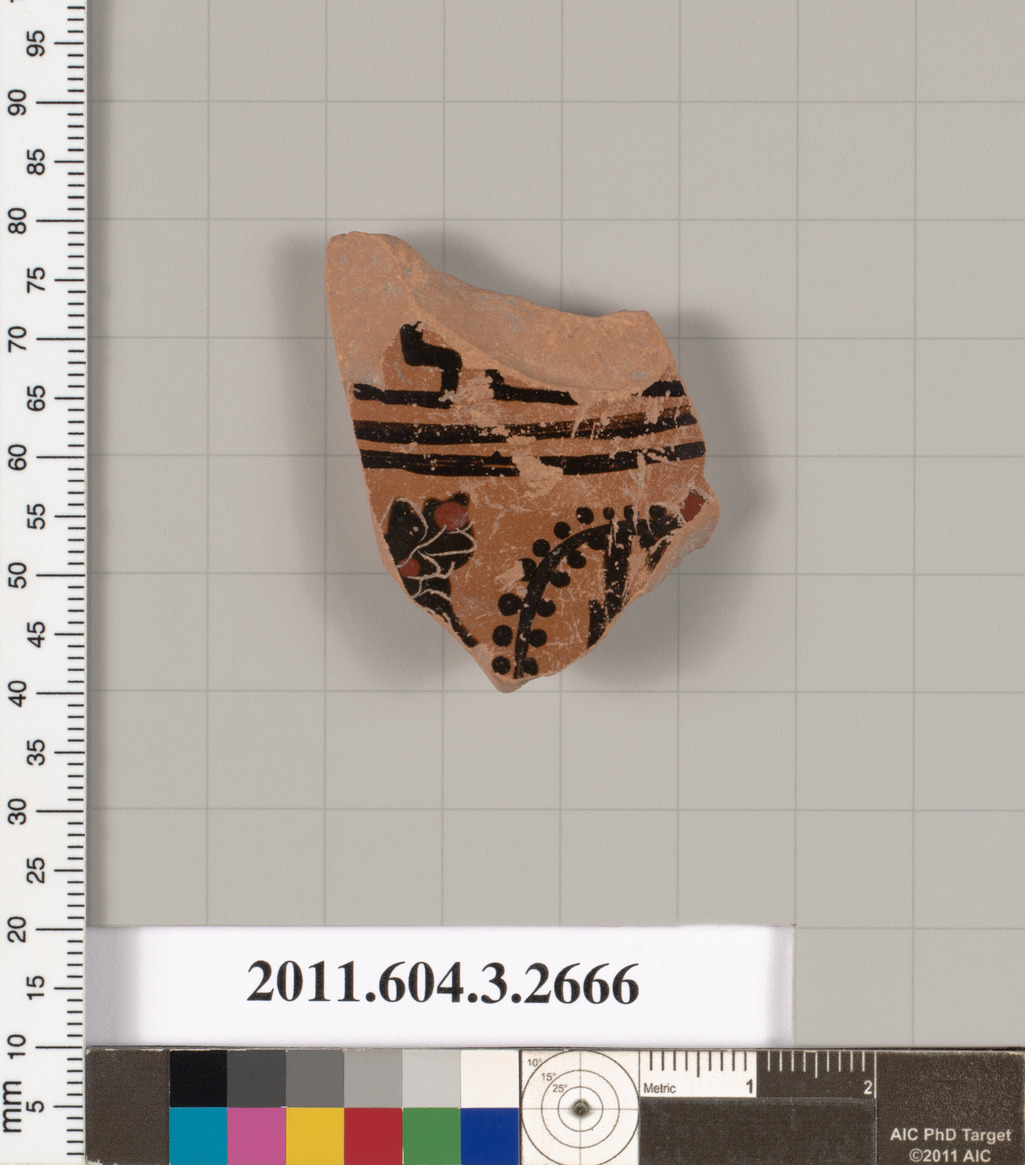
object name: olpe fragment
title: Terracotta fragment of an olpe (jug)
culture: greek, attic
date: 525-501 BCE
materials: terracotta